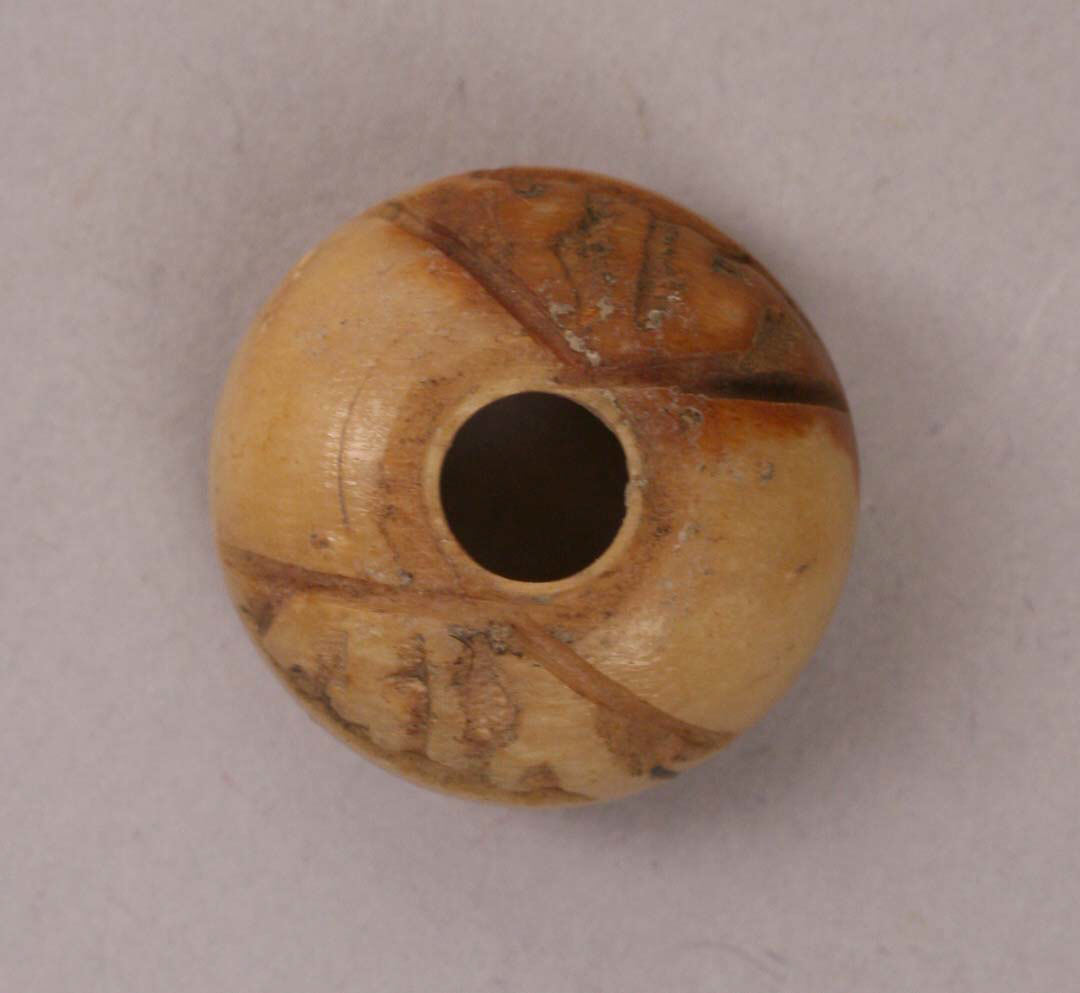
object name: button or bead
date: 801-1000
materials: bone, paint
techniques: incising, inlay, tinting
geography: iran